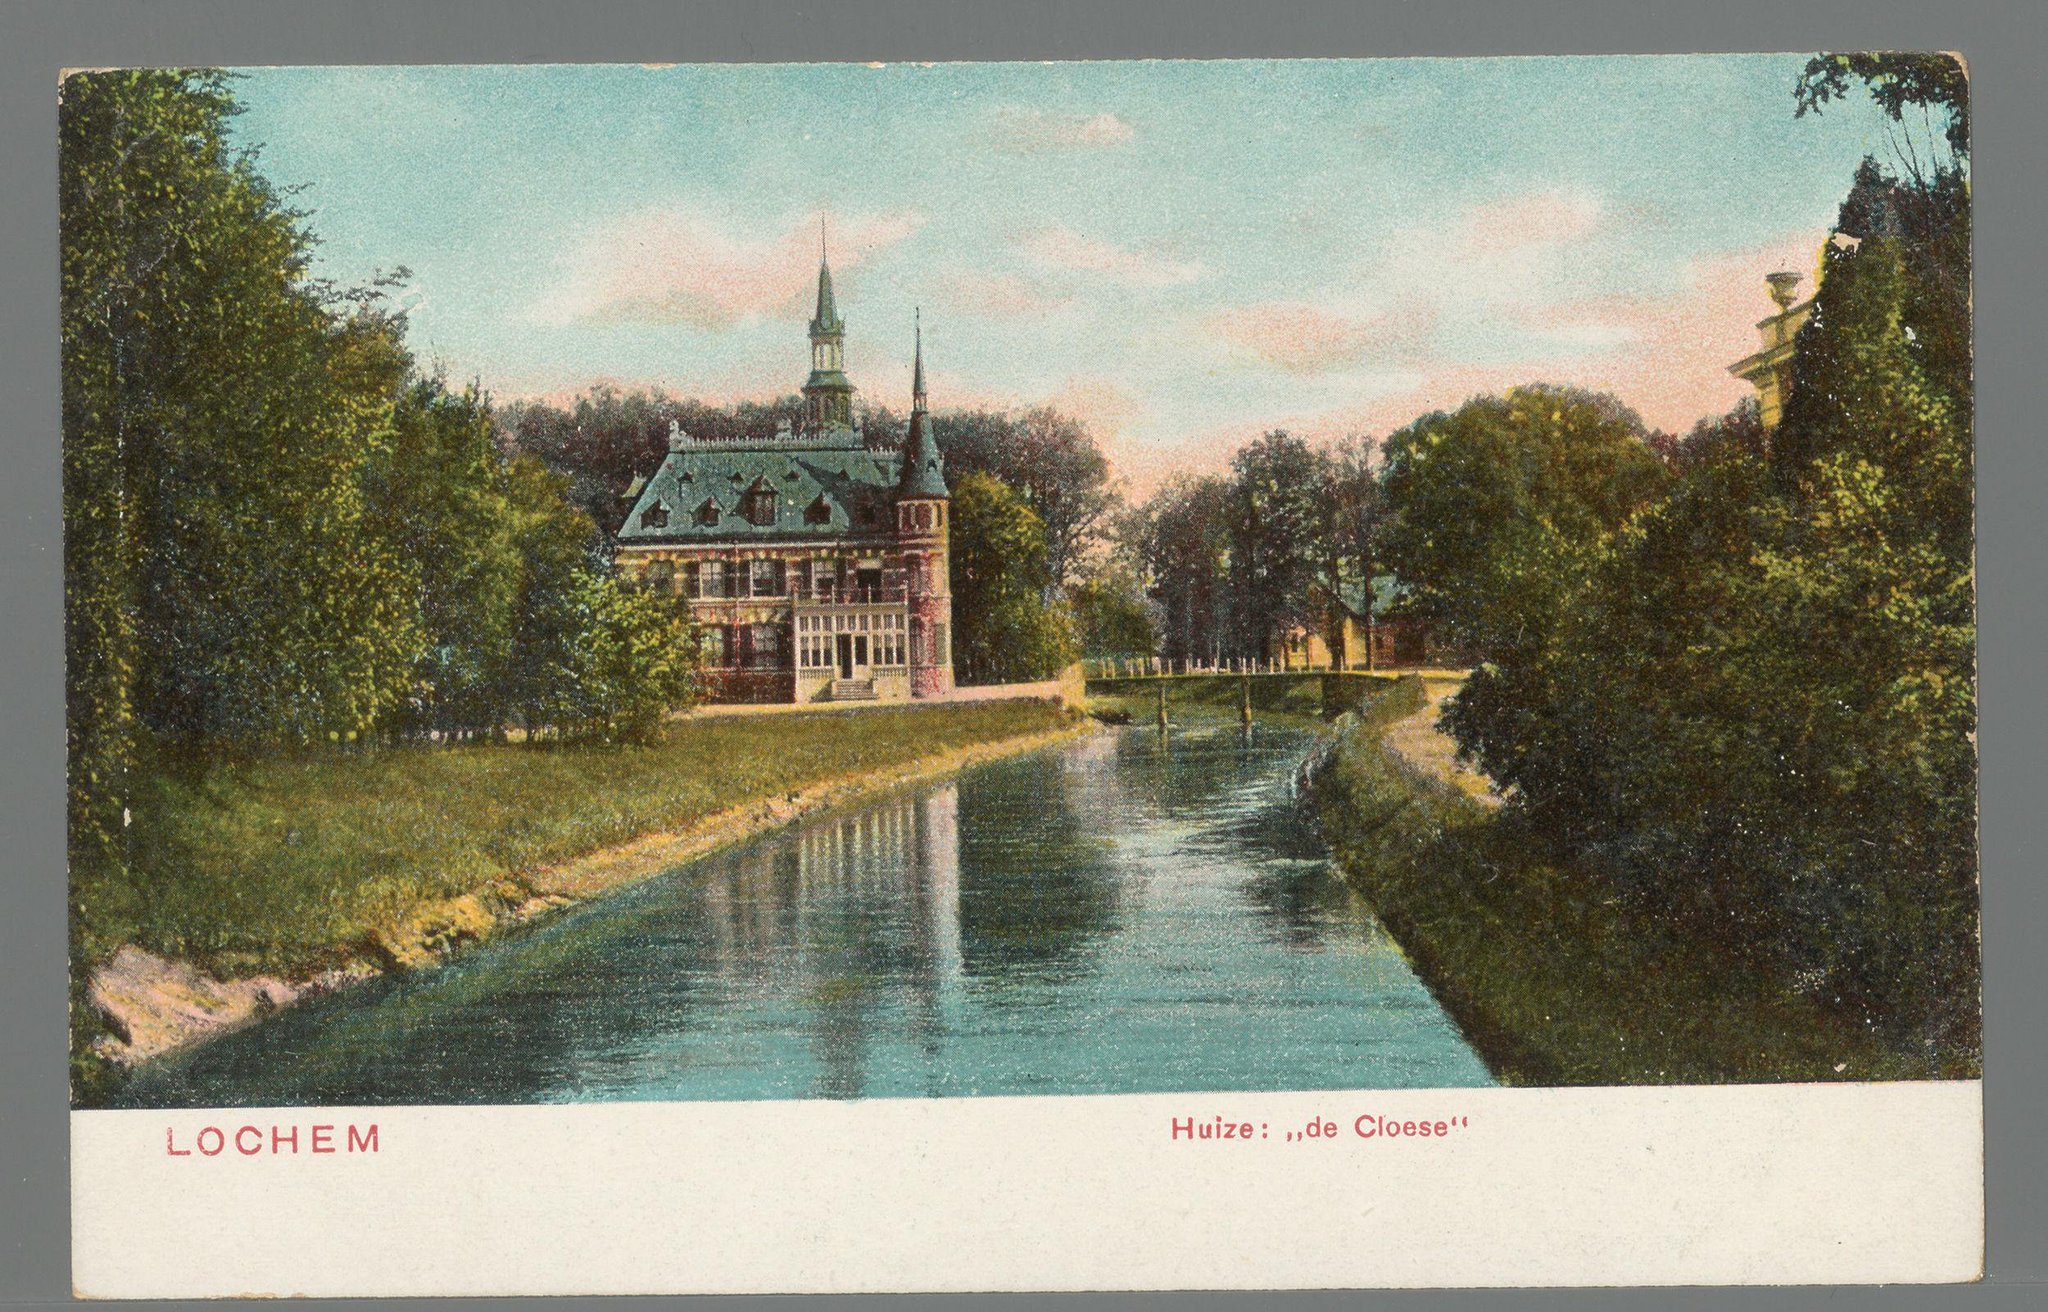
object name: ansichtkaart, prentbriefkaart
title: Lochem. Huize: "de Cloese"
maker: Anonymous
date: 1905-1906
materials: cardboard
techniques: lithograph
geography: leipzig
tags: castle, canal